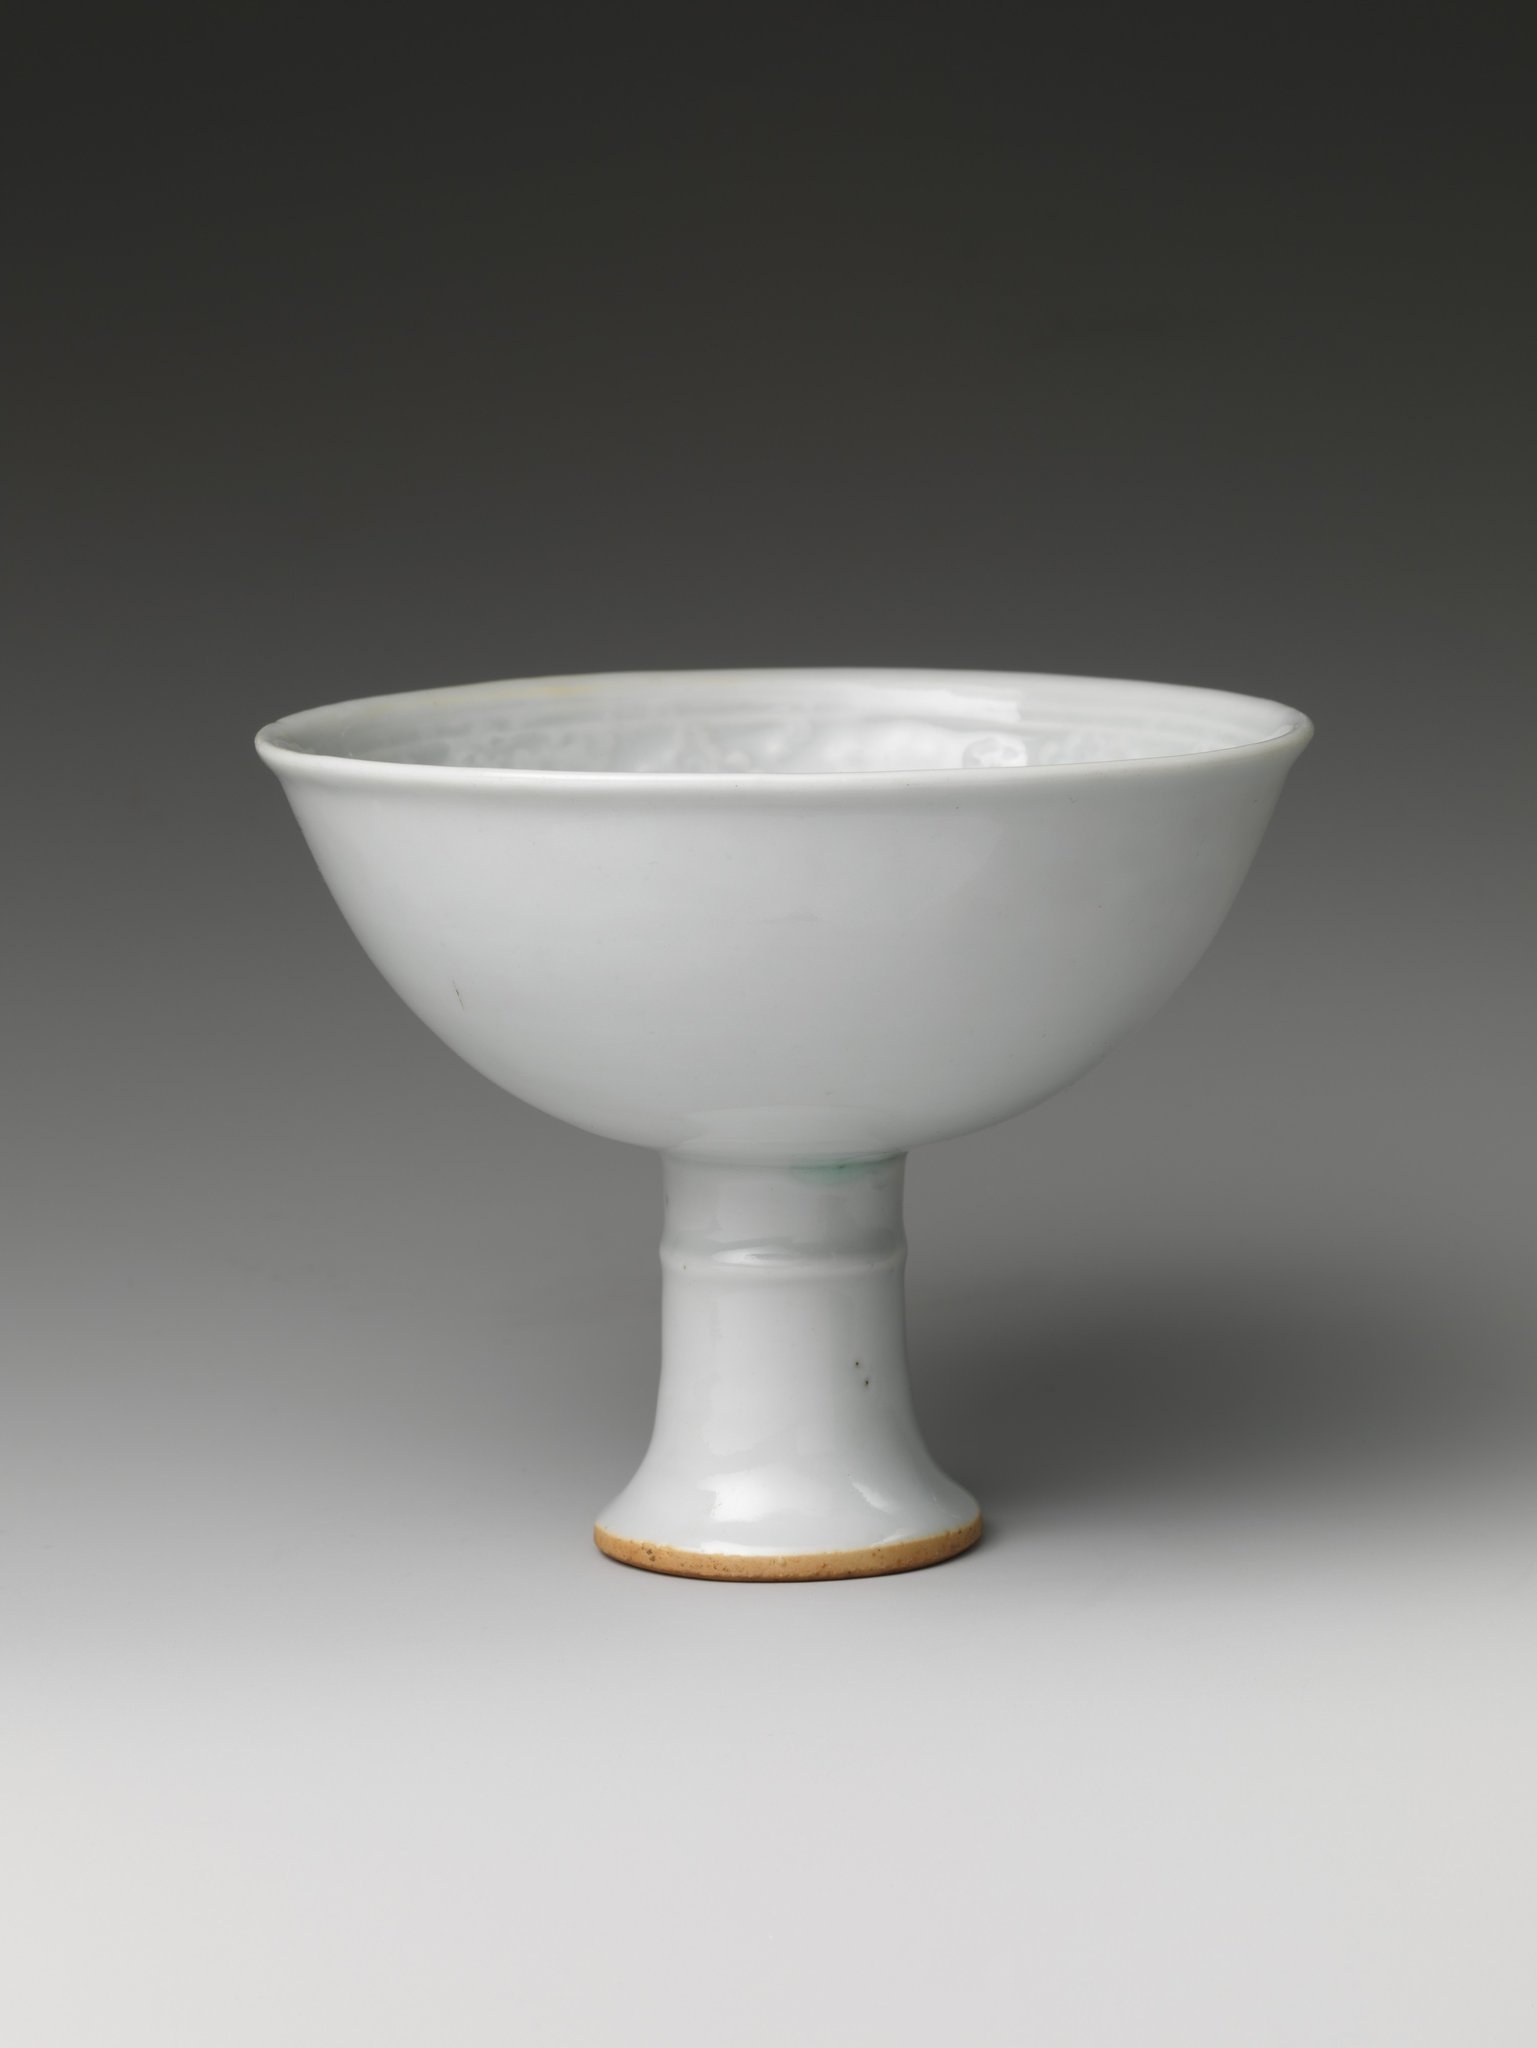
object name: stem cup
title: Stem Cup with Chrysanthemum Scroll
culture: chinese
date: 1301-1400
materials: glaze, porcelain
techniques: molding